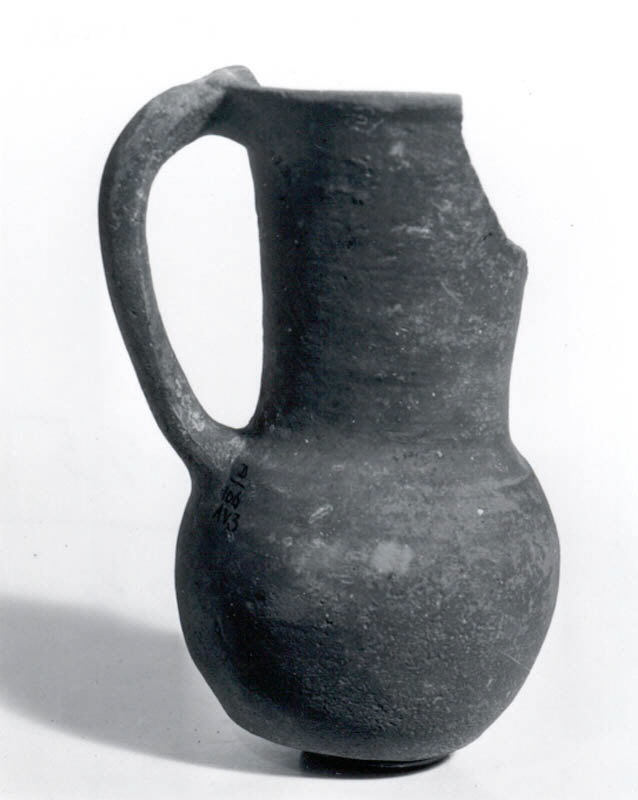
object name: jug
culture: israelite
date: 734-601 BCE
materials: ceramic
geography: levant